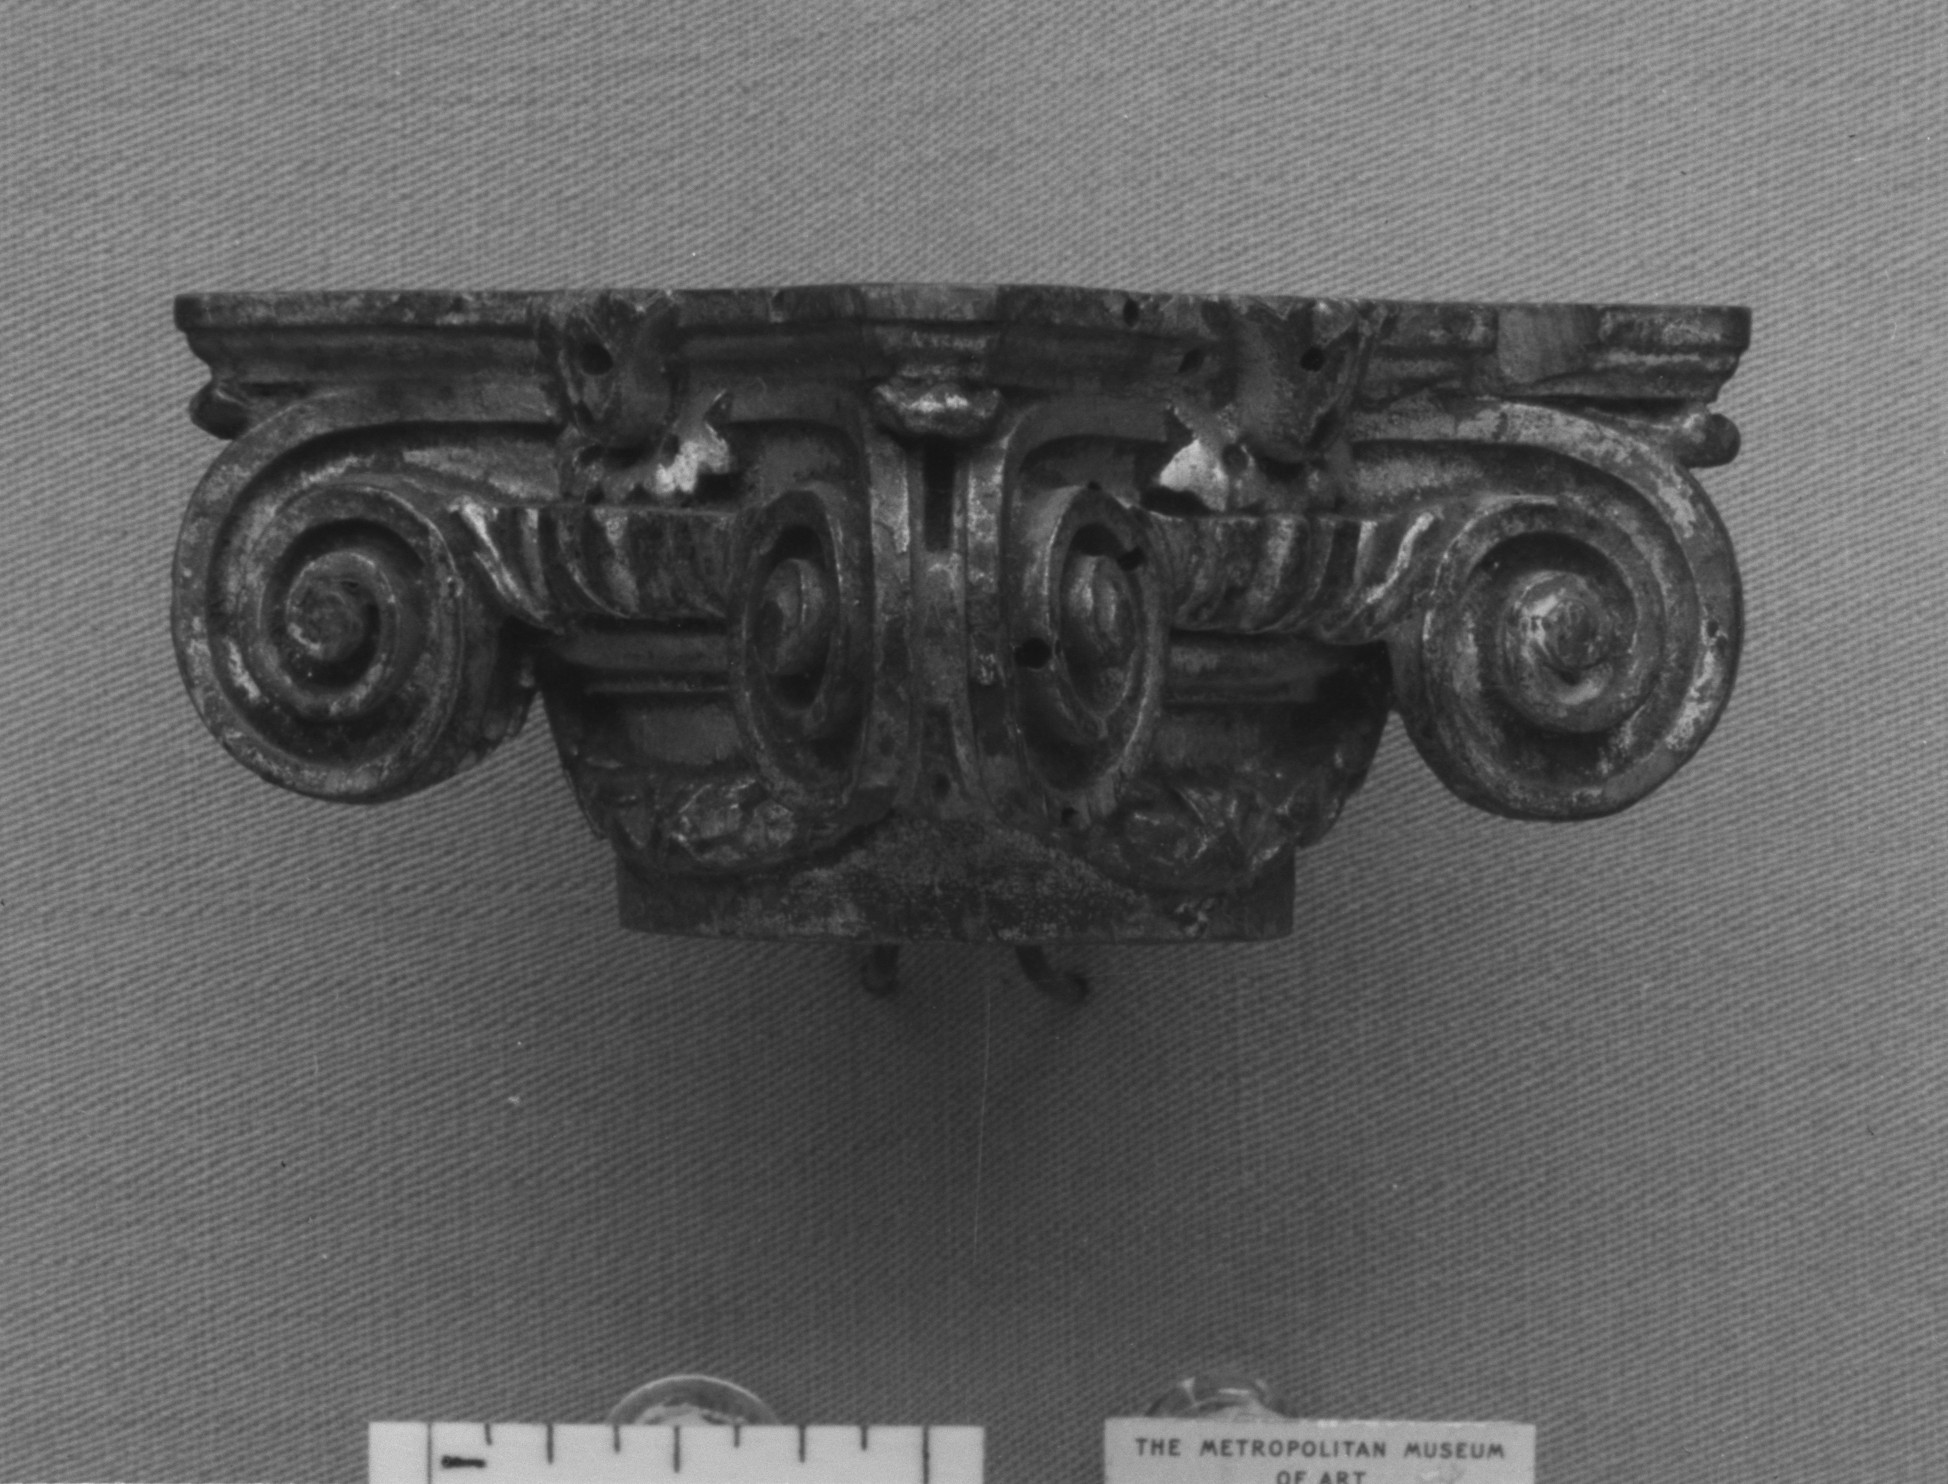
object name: capital detail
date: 1701-1800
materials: gilt, wood